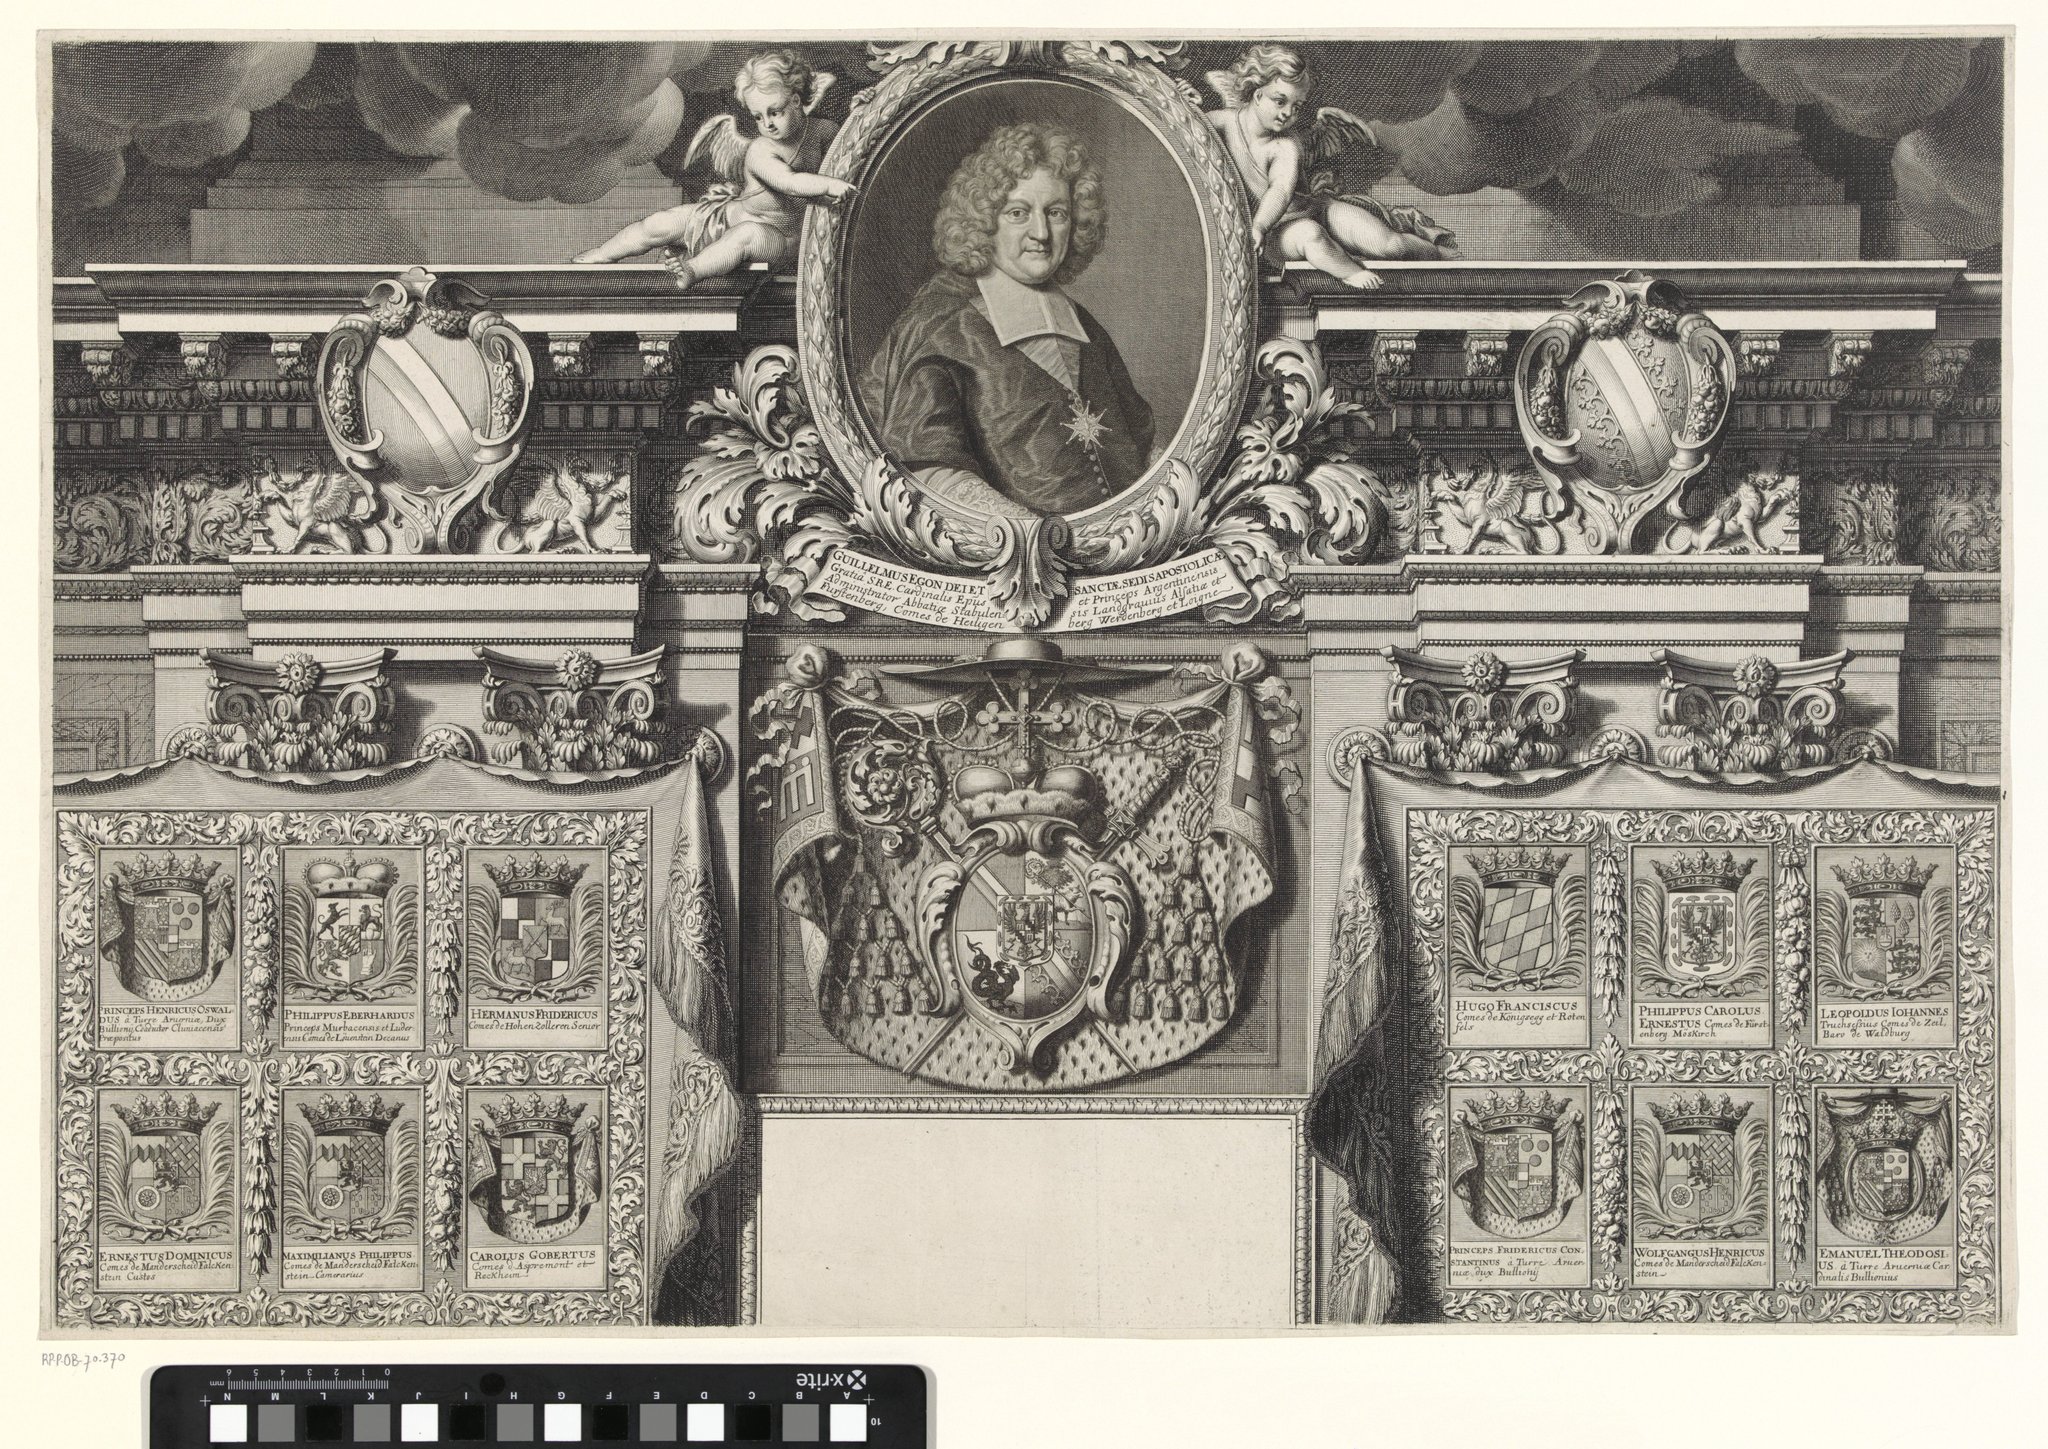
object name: print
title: Allegorisch portret van Wilhelm Egon von Fürstenberg-Heiligenberg, onderste deel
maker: hans witdoeck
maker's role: print maker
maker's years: 1615-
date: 1630-1642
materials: paper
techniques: engraving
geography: antwerp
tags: knighthood order of the holy spirit, armorial bearing, heraldry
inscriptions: collector's mark: Lugt 240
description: Portret van Wilhelm Egon von Fürstenberg-Heiligenberg. Hij draagt de Orde van de Heilige Geest op zijn borst. Zijn portret is omlijst met lauwertakken. Op de banderol eronder een vierregelig opschrift met zijn naam en titels in het Latijn. Daaronder een draperie met zijn wapenschild en een leeg kader. Aan weerszijden diverse wapens van Duitse edelen.